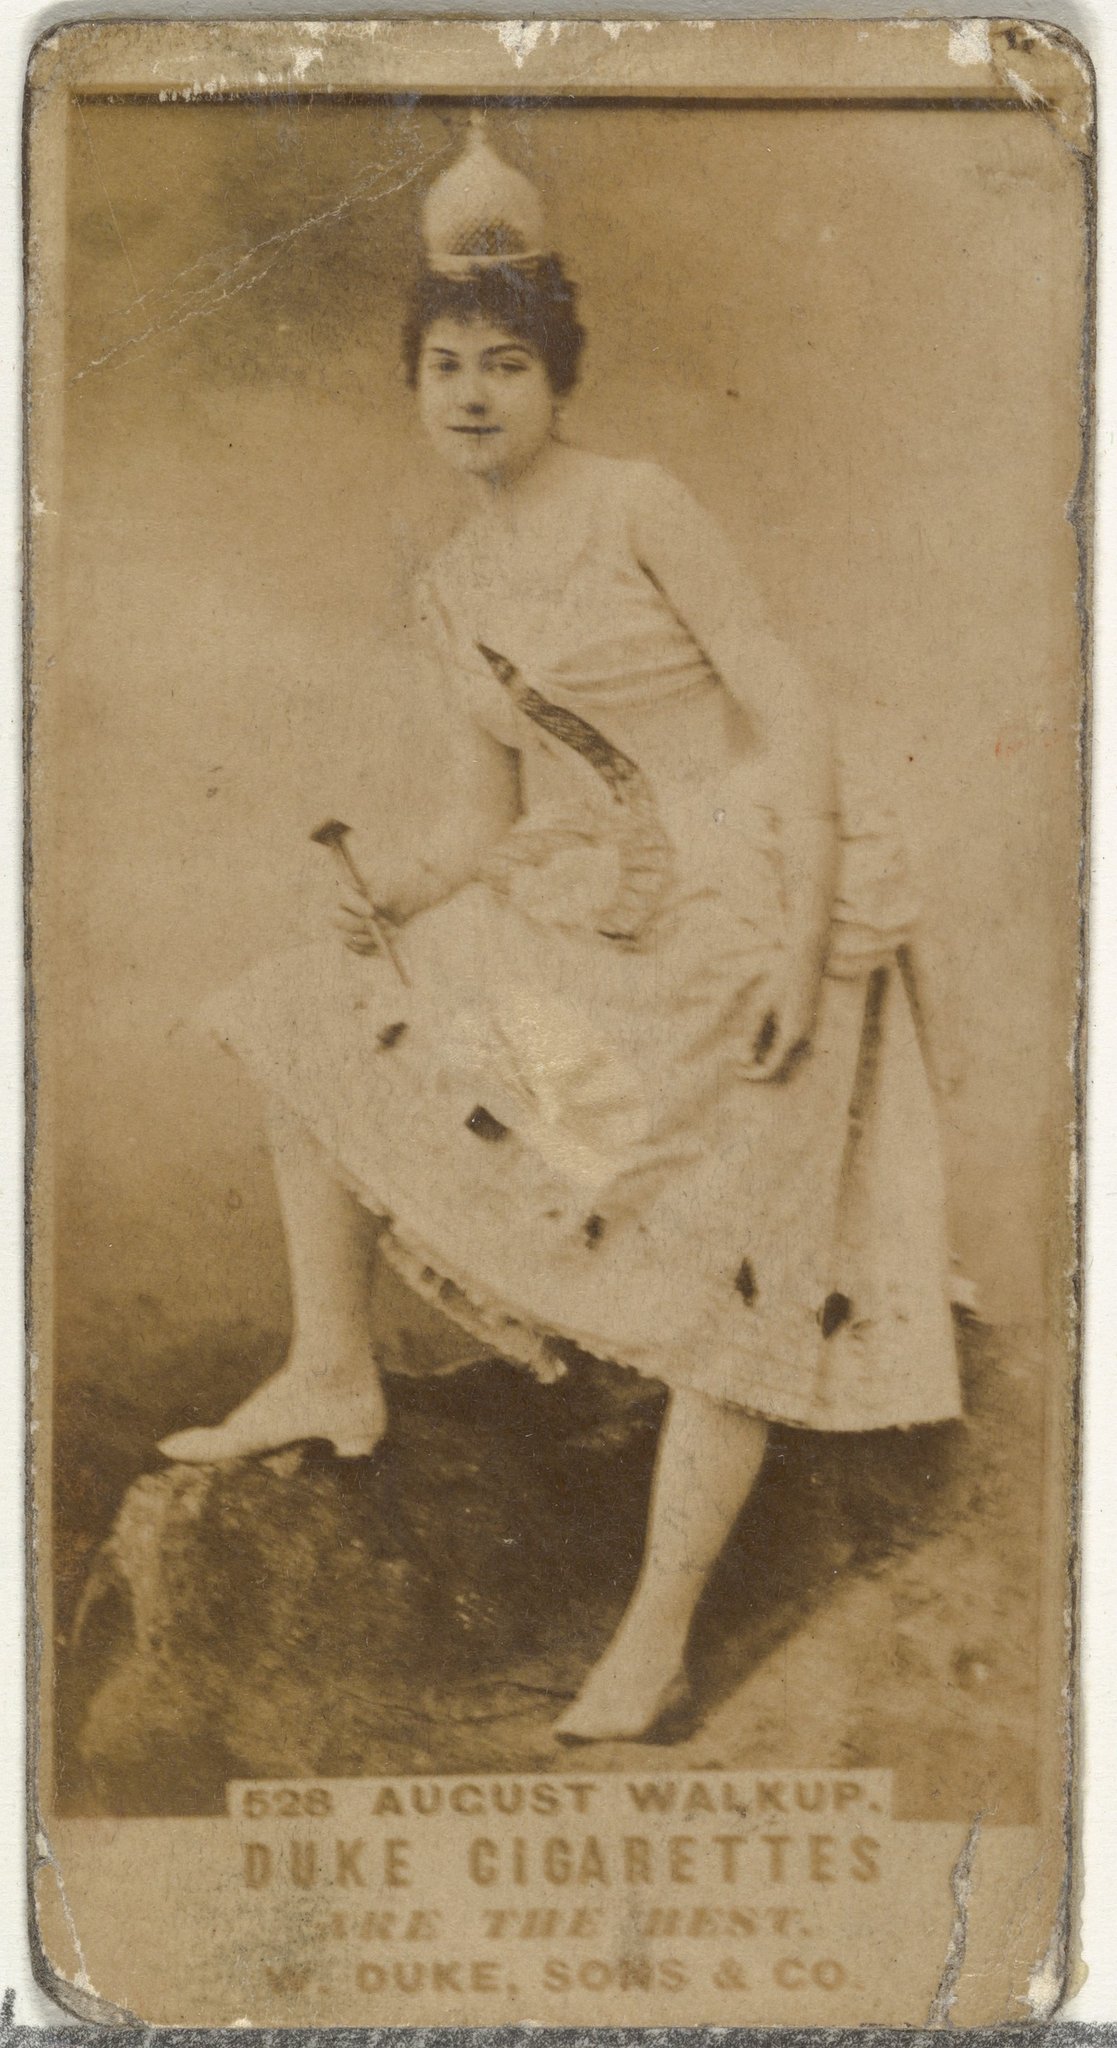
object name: photograph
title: Card Number 528, August Walkup, from the Actors and Actresses series (N145-7) issued by Duke Sons & Co. to promote Duke Cigarettes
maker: w. duke, sons & co.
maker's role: publisher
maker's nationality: american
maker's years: 1870-1920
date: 1880-1889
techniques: albumen silver print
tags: portraits,women,actresses